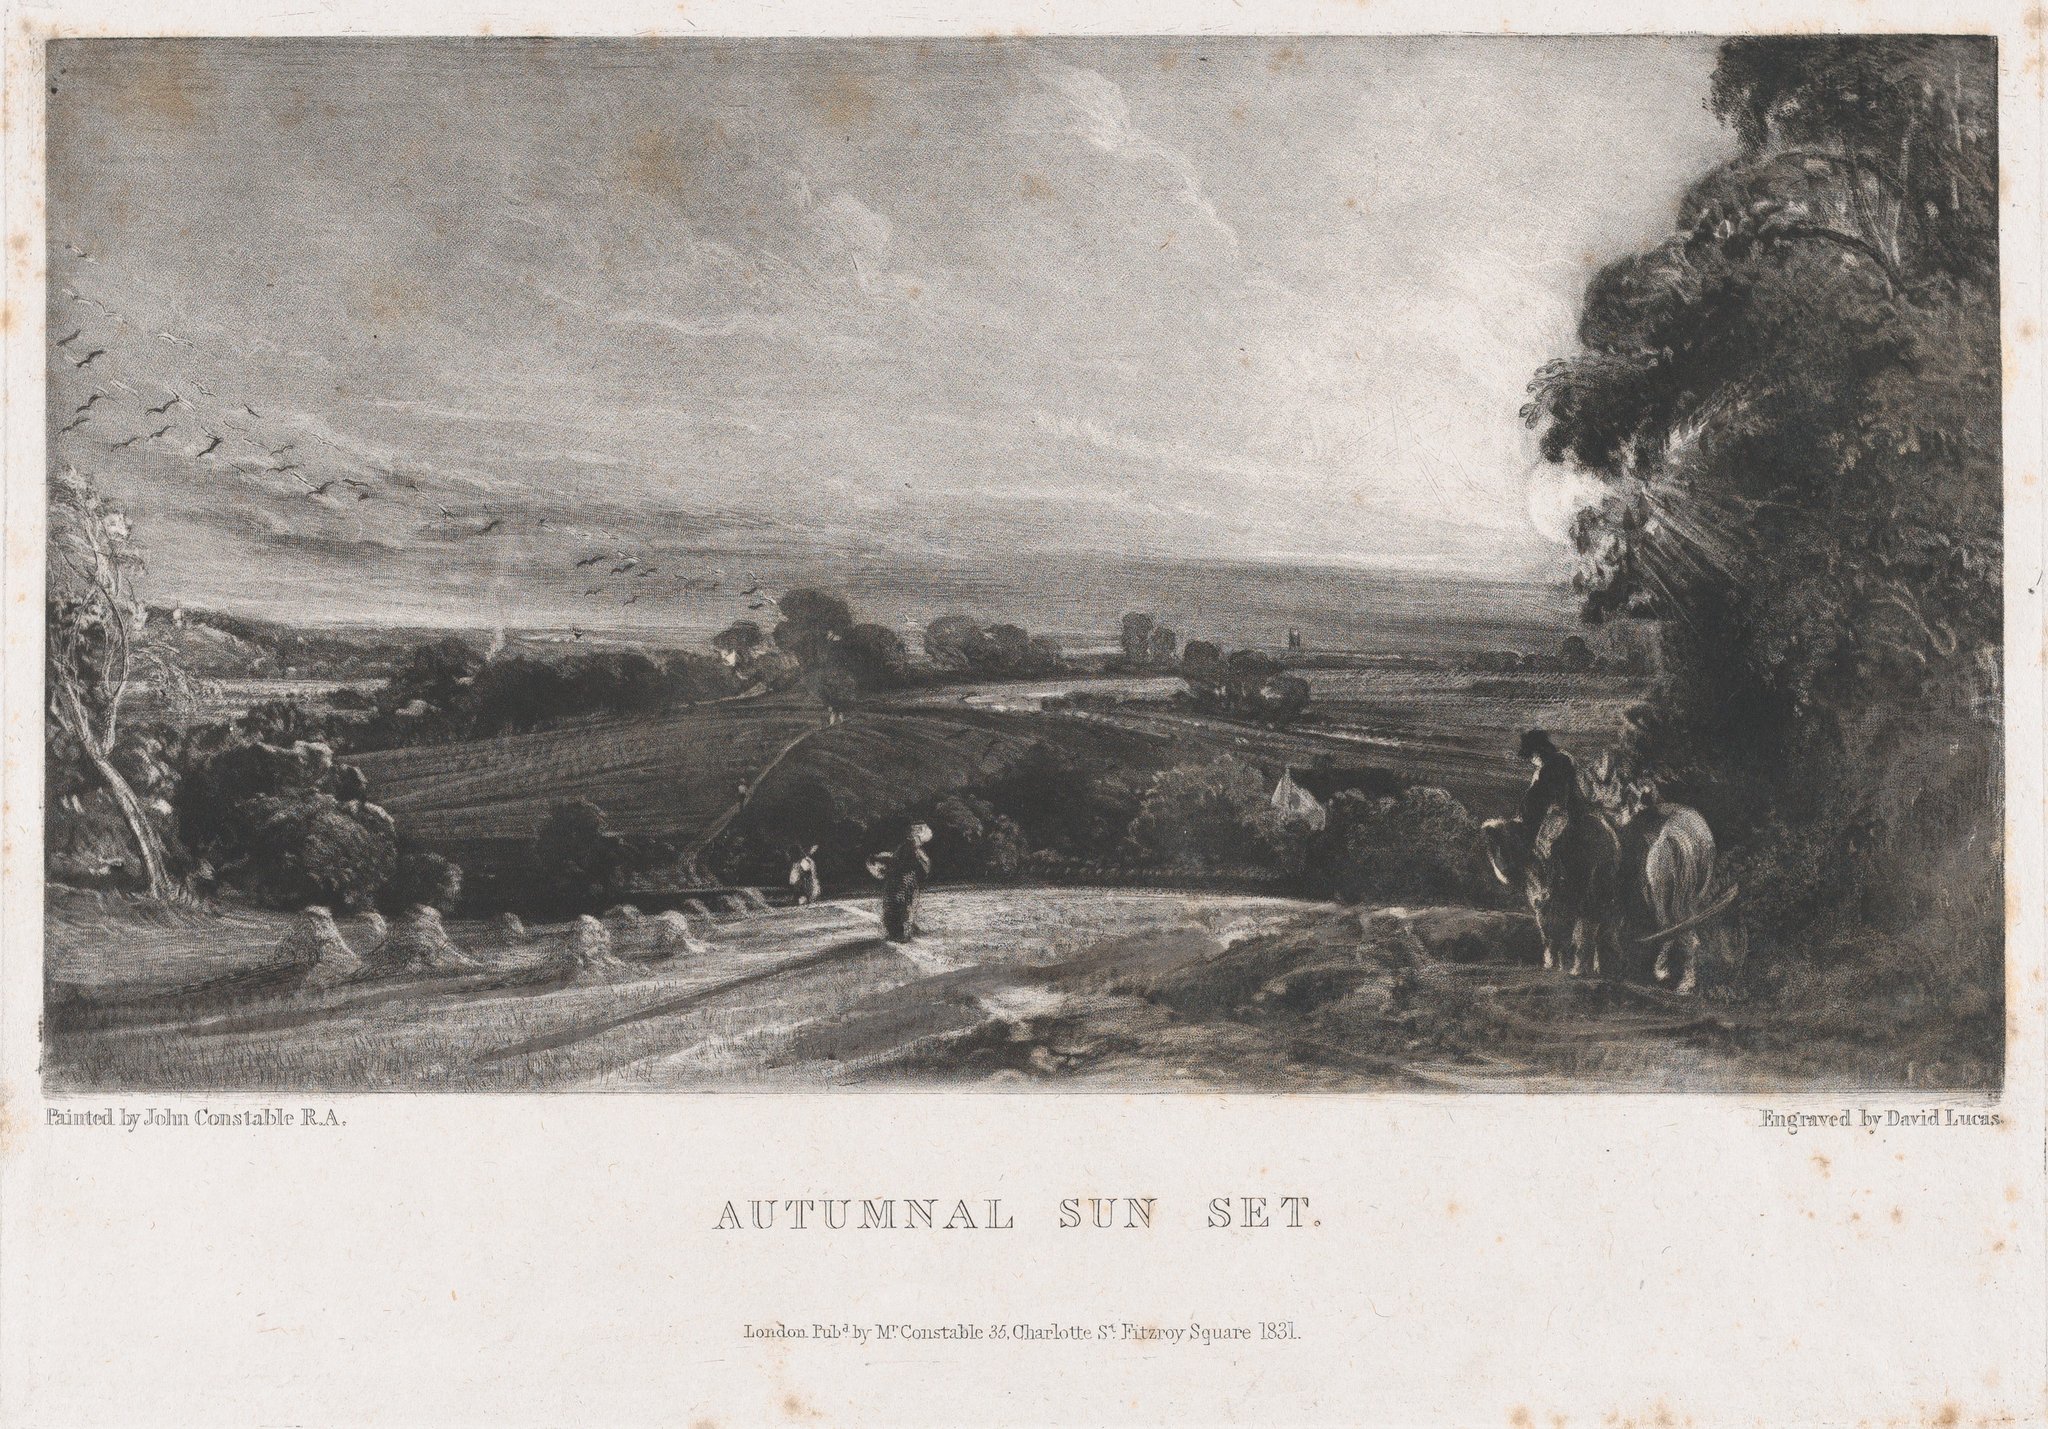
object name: print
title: Autumnal Sunset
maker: david lucas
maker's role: artist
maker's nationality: british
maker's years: 1802-1881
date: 1831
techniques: mezzotint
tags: human figures,landscapes,autumn